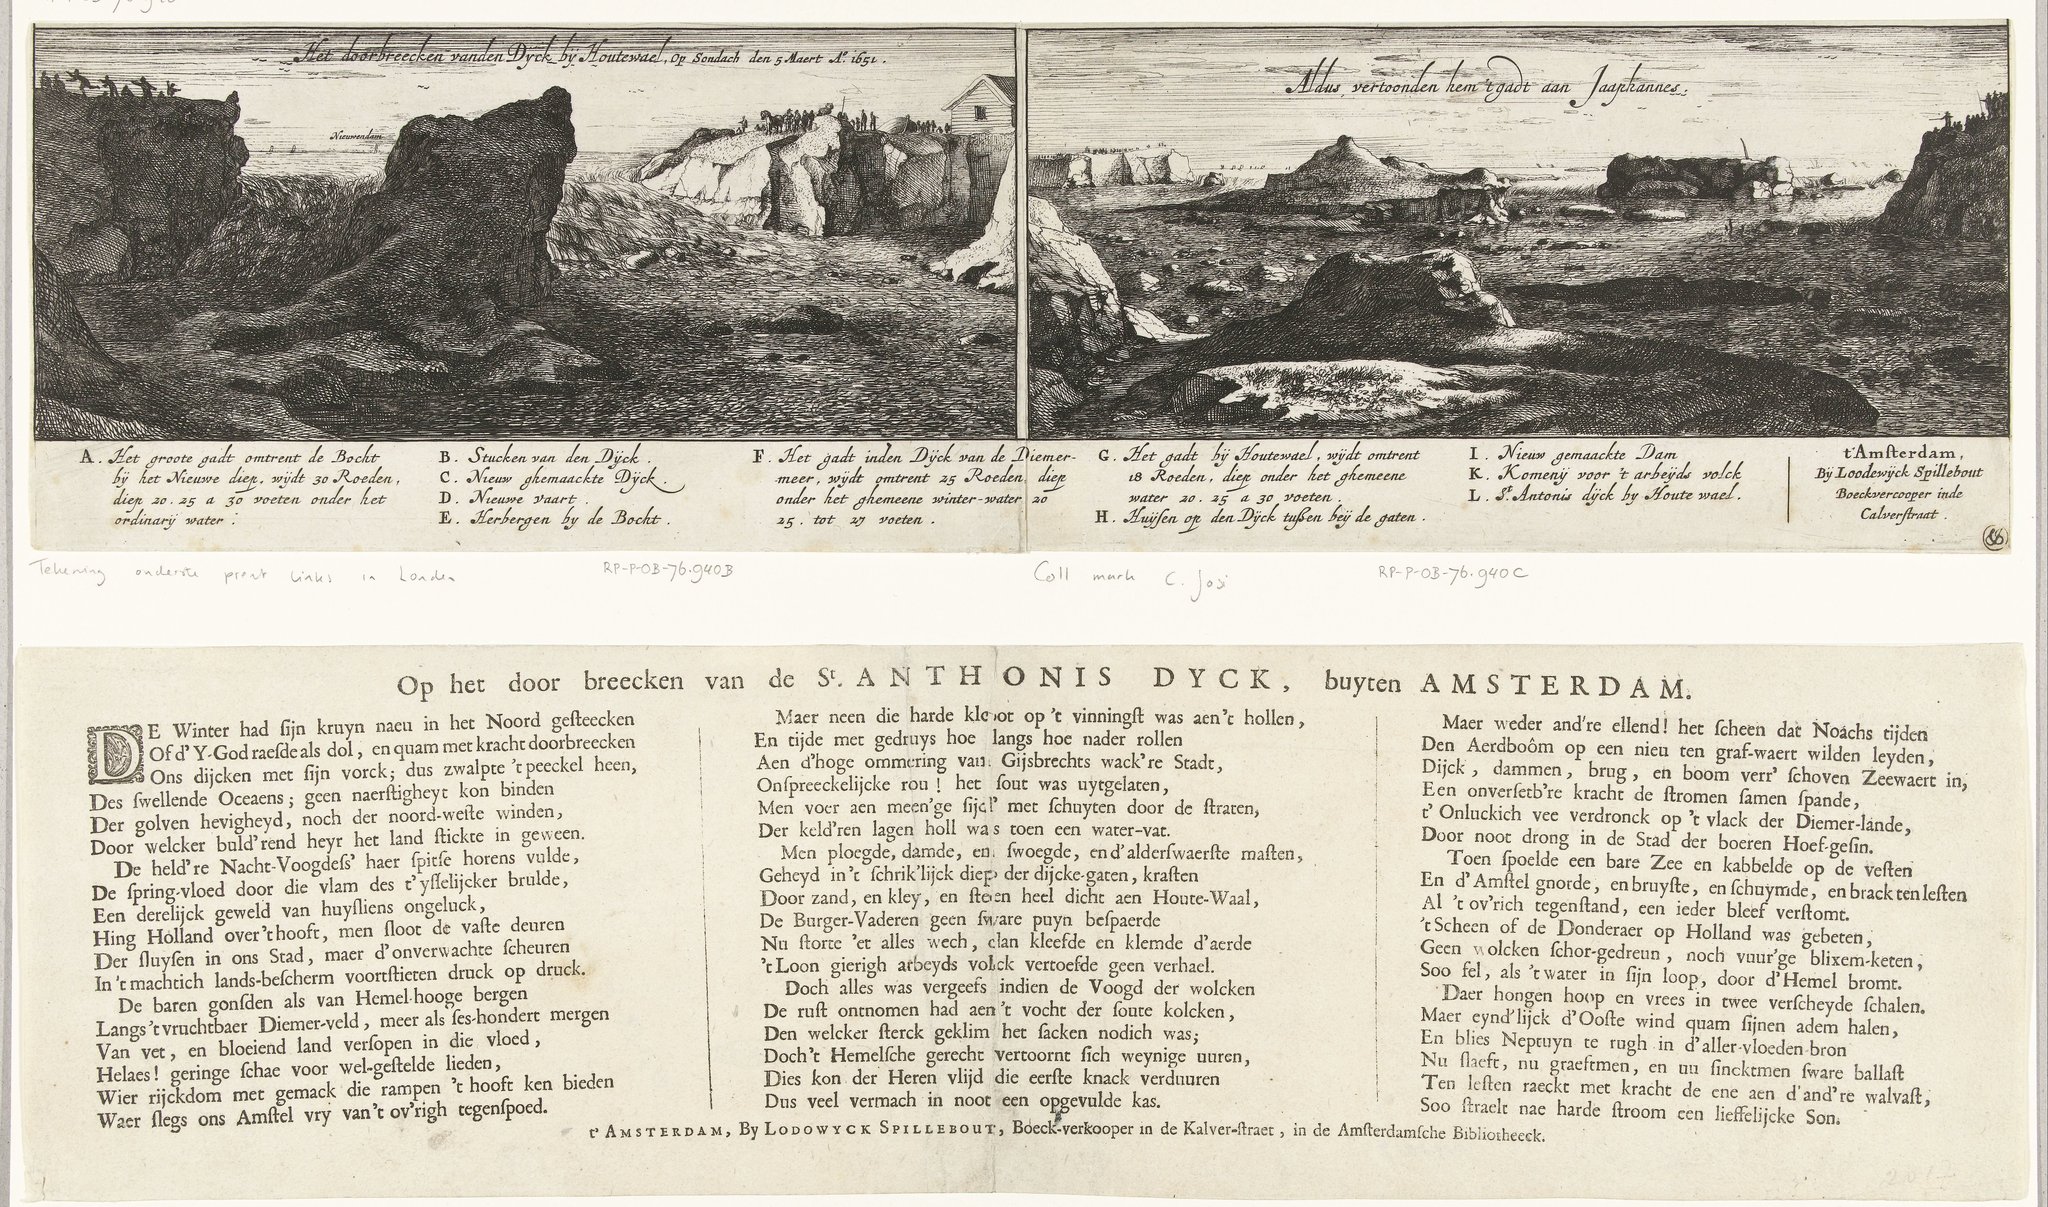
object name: text sheet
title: Gedicht op het doorbreken van de Sint-Antoniesdijk, 1651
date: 1651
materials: paper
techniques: letterpress printing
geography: amsterdam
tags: dike-break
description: Tekstblad met een gedicht op het doorbreken van de Sint-Antoniesdijk of Diemerzeedijk op 5 maart 1651.Tekst in drie kolommen. Onderdeel van een grote plaat bestaande uit vier afbeeldingen en een tekstblad met een vers.